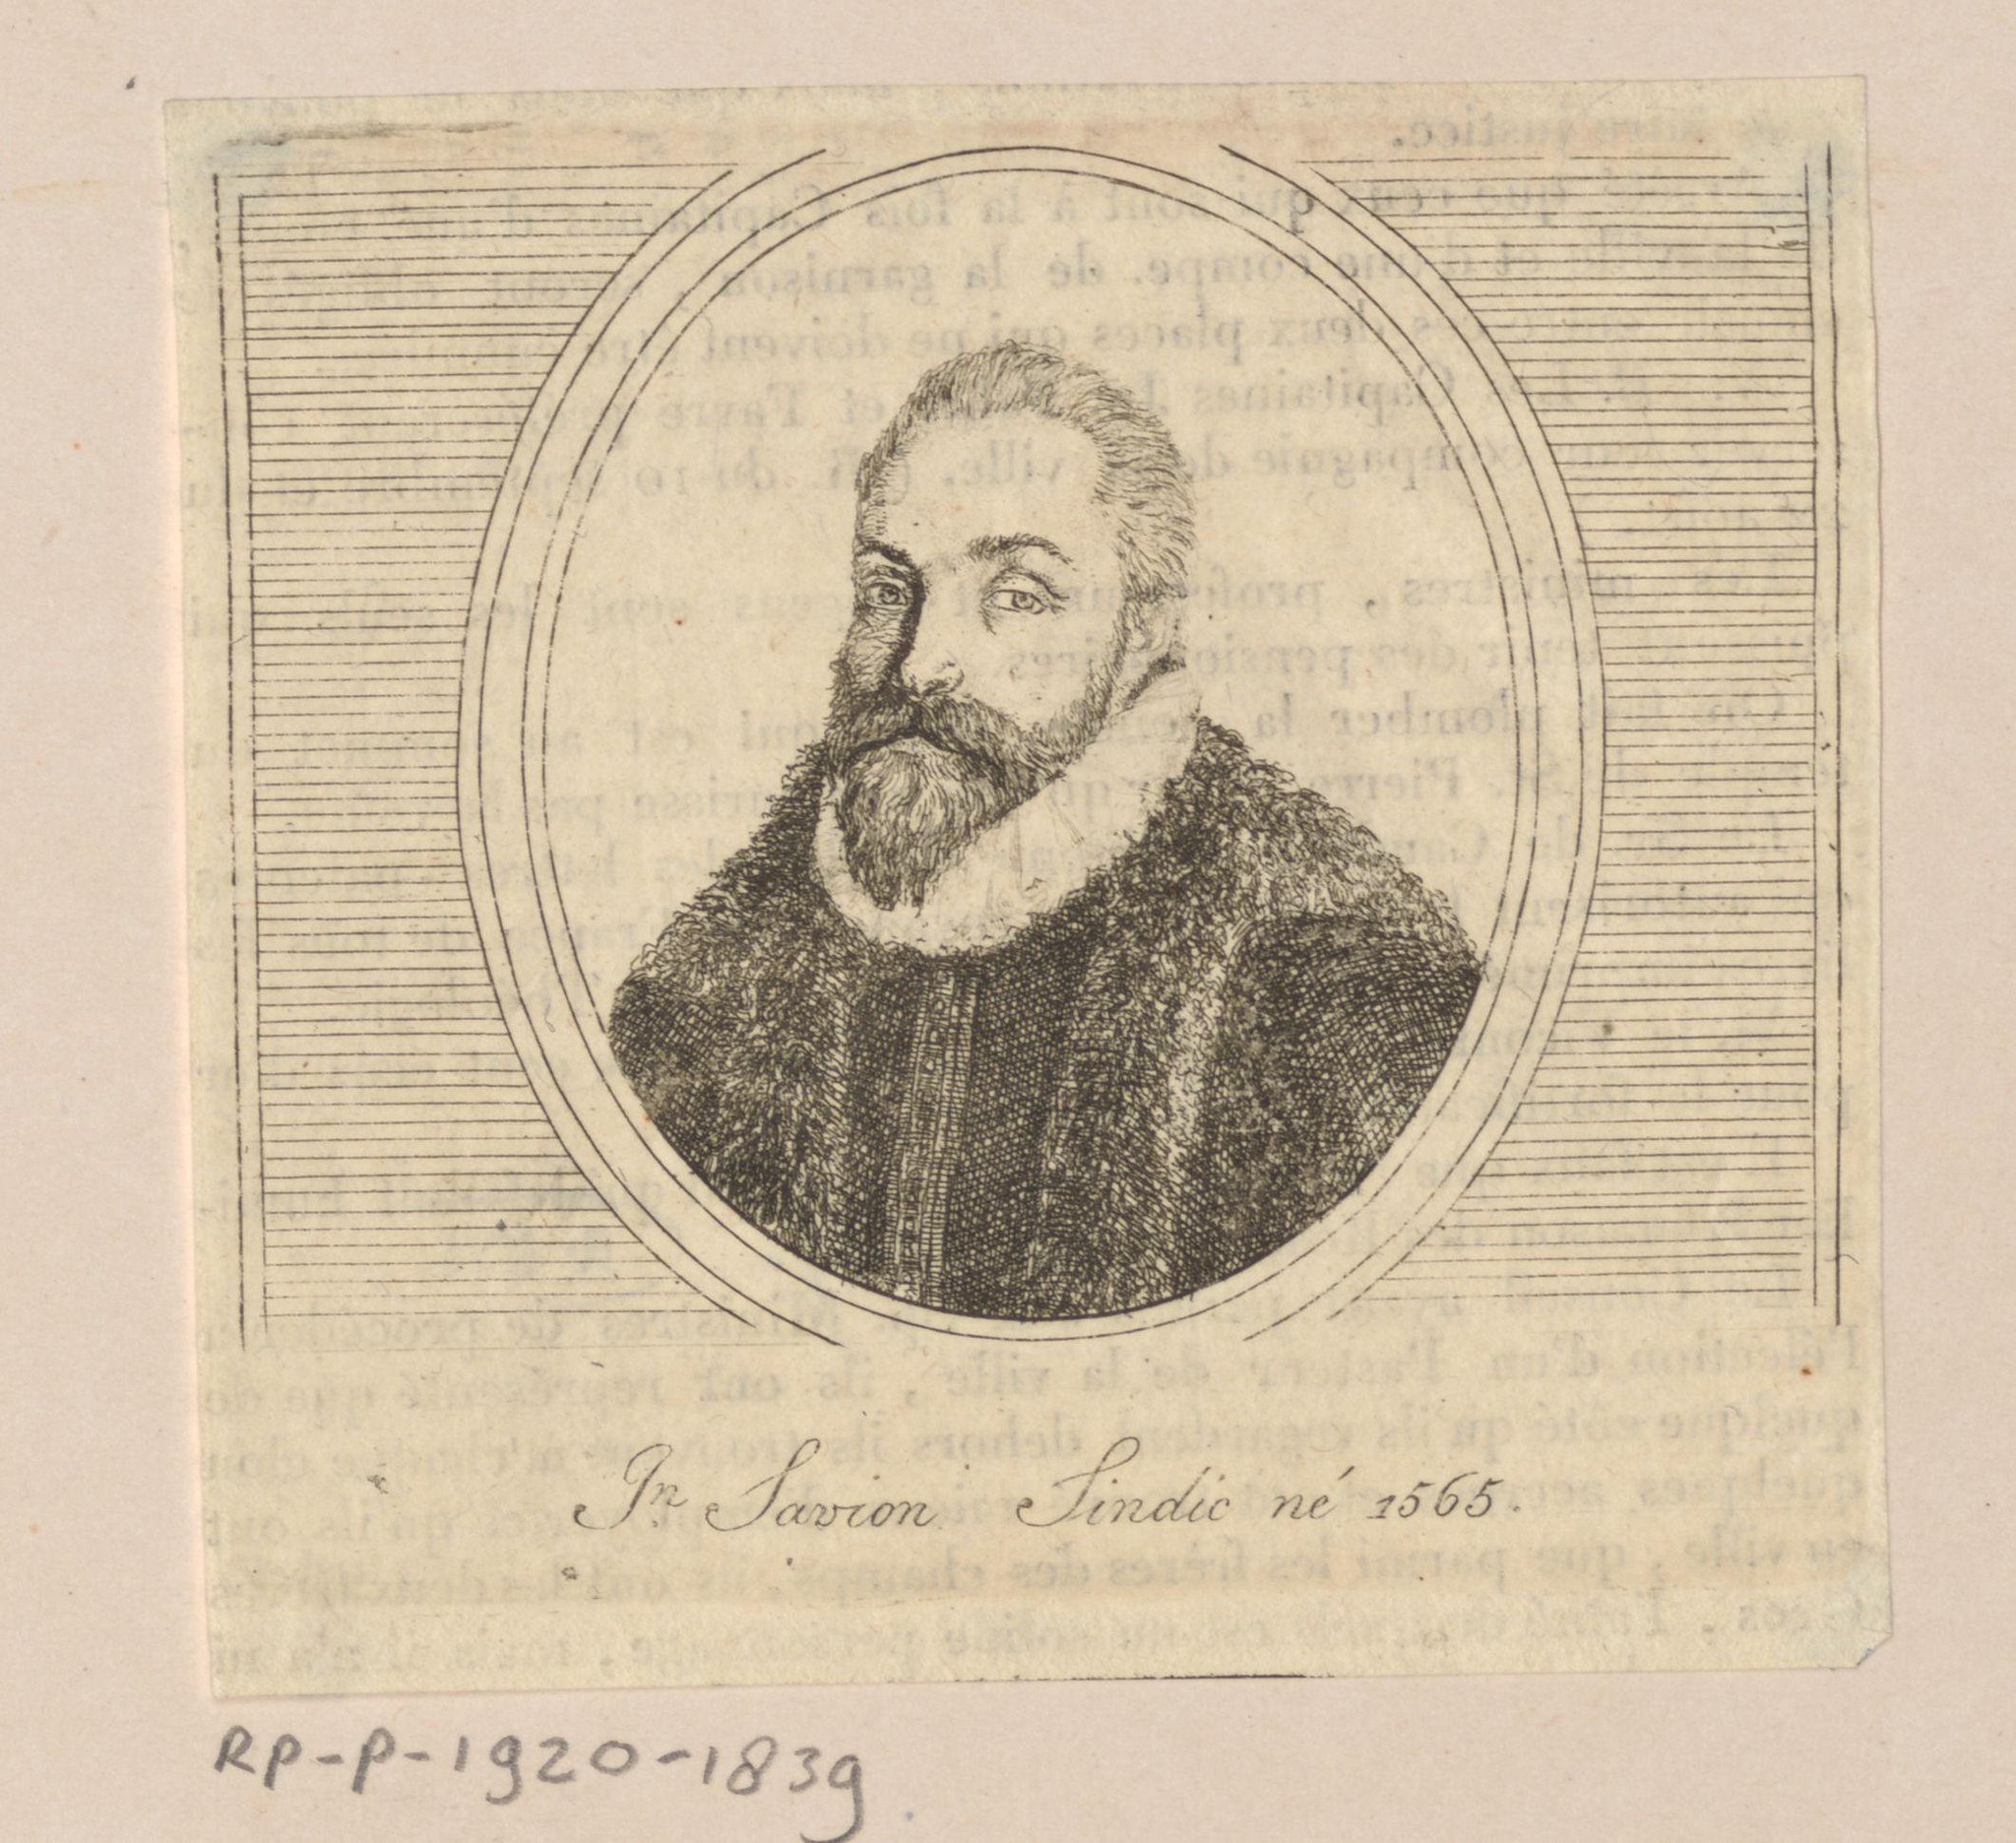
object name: print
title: Portret van Jean Savion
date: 1815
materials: paper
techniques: etching, letterpress printing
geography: geneva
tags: historical persons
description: Prent uit: Grenus, Théodore de. Fragmens biographiques et historiques. Extraits des registres du Conseil (...). Genève: Manget et Cherbuliez, 1815.